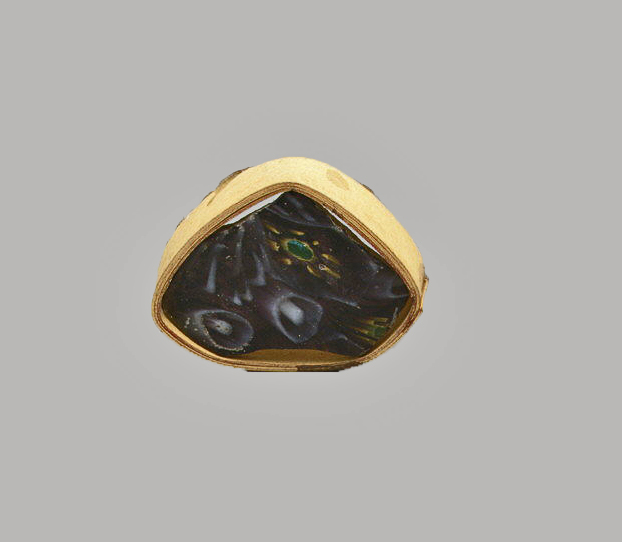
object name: fragment, mosaic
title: Glass mosaic fragment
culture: roman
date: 34 BCE-33 CE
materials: glass